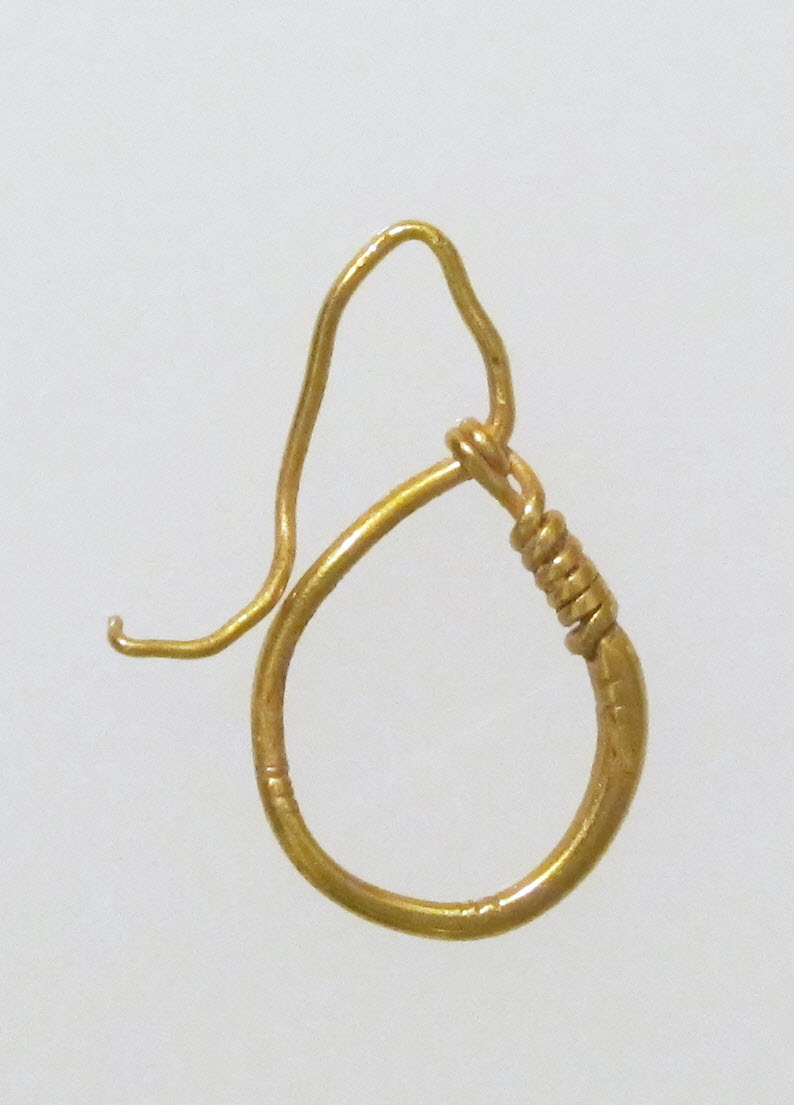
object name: earring, delta shaped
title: Earring, delta-shaped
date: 7000 BCE-330 CE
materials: gold